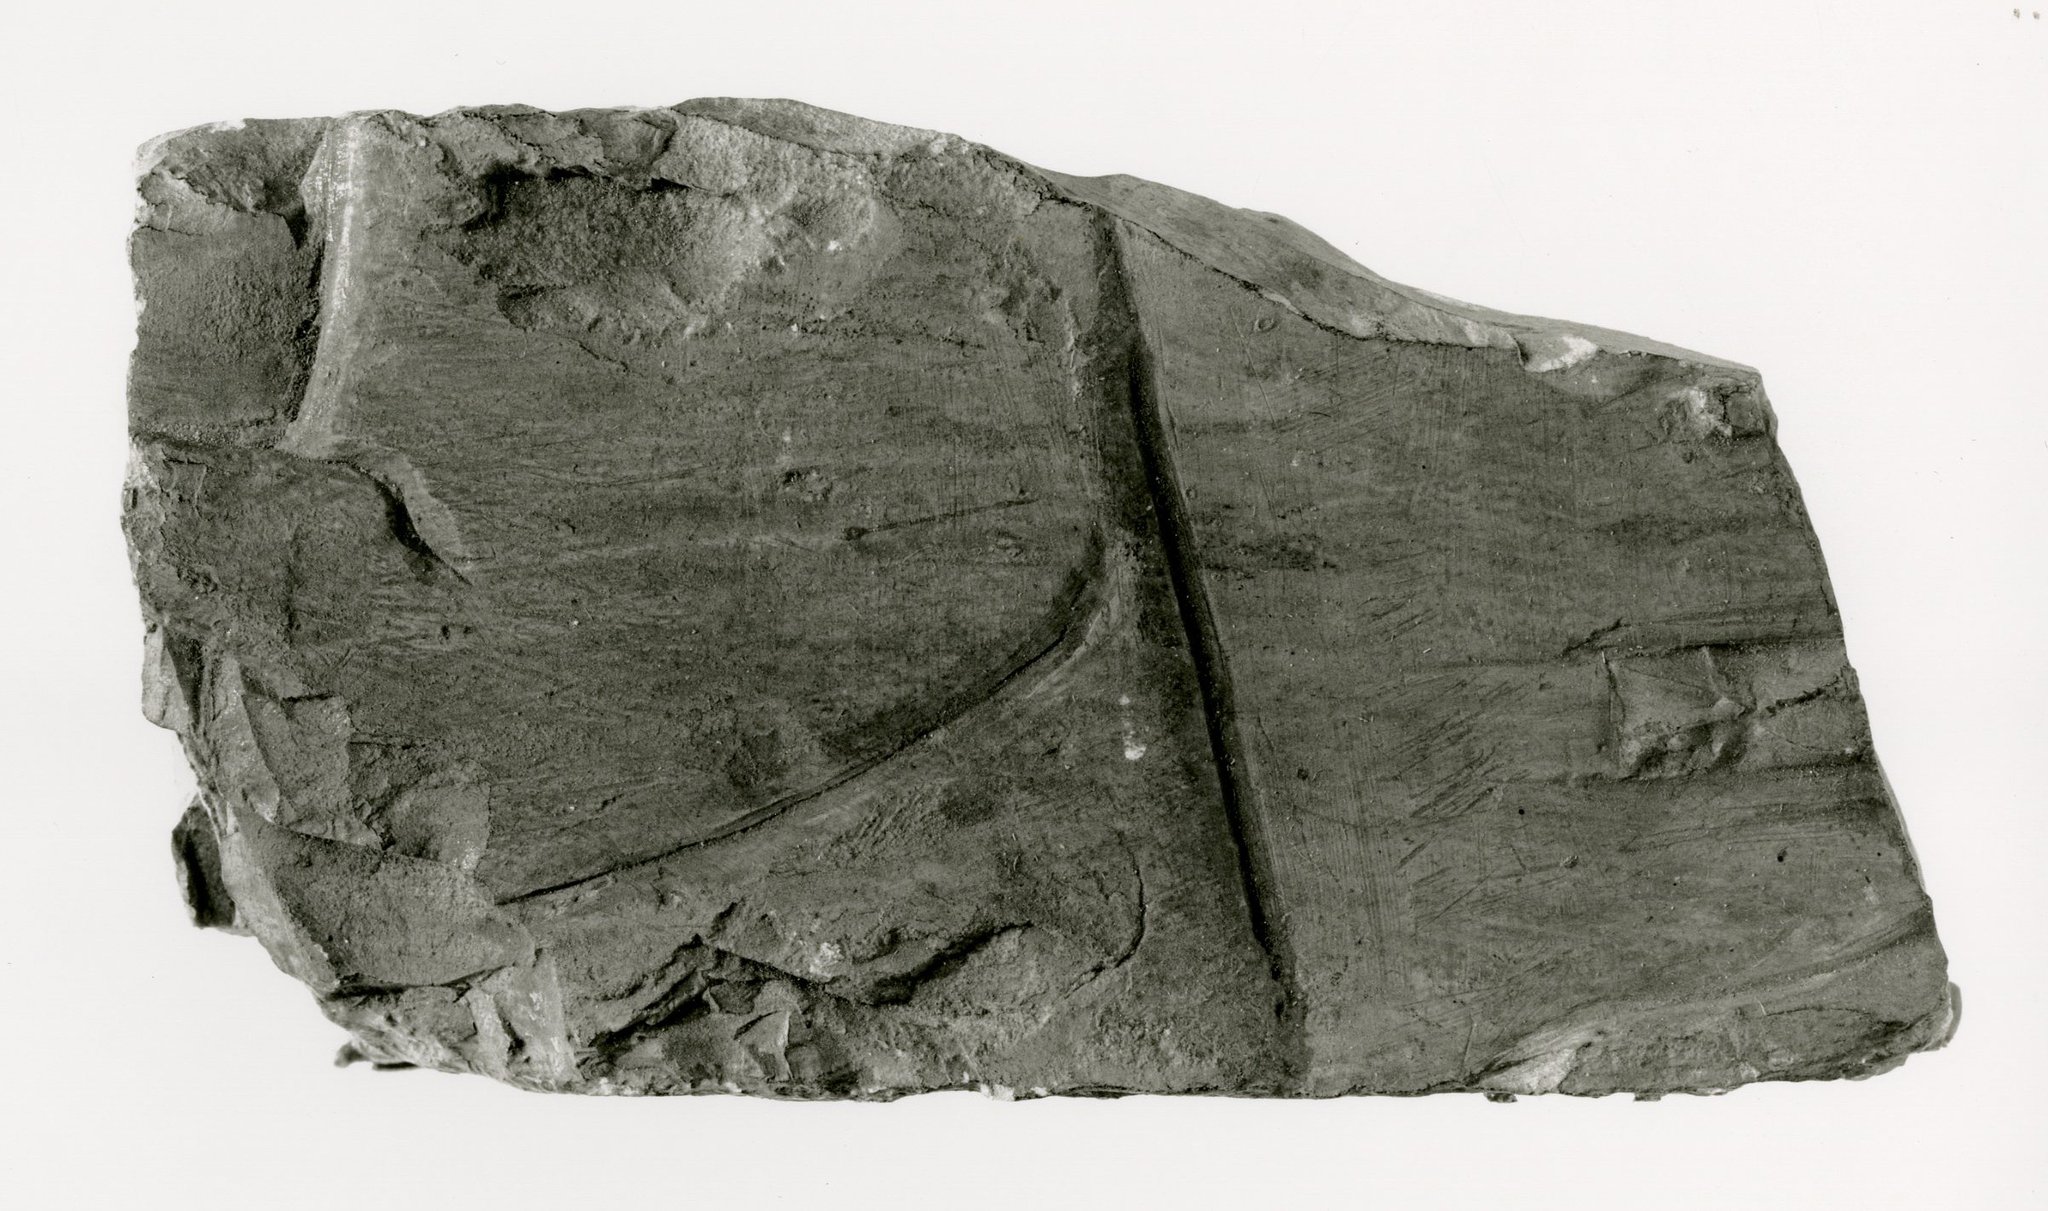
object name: relief, tomb of nespekashuty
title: Raised relief fragment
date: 664-610 BCE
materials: limestone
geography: egypt